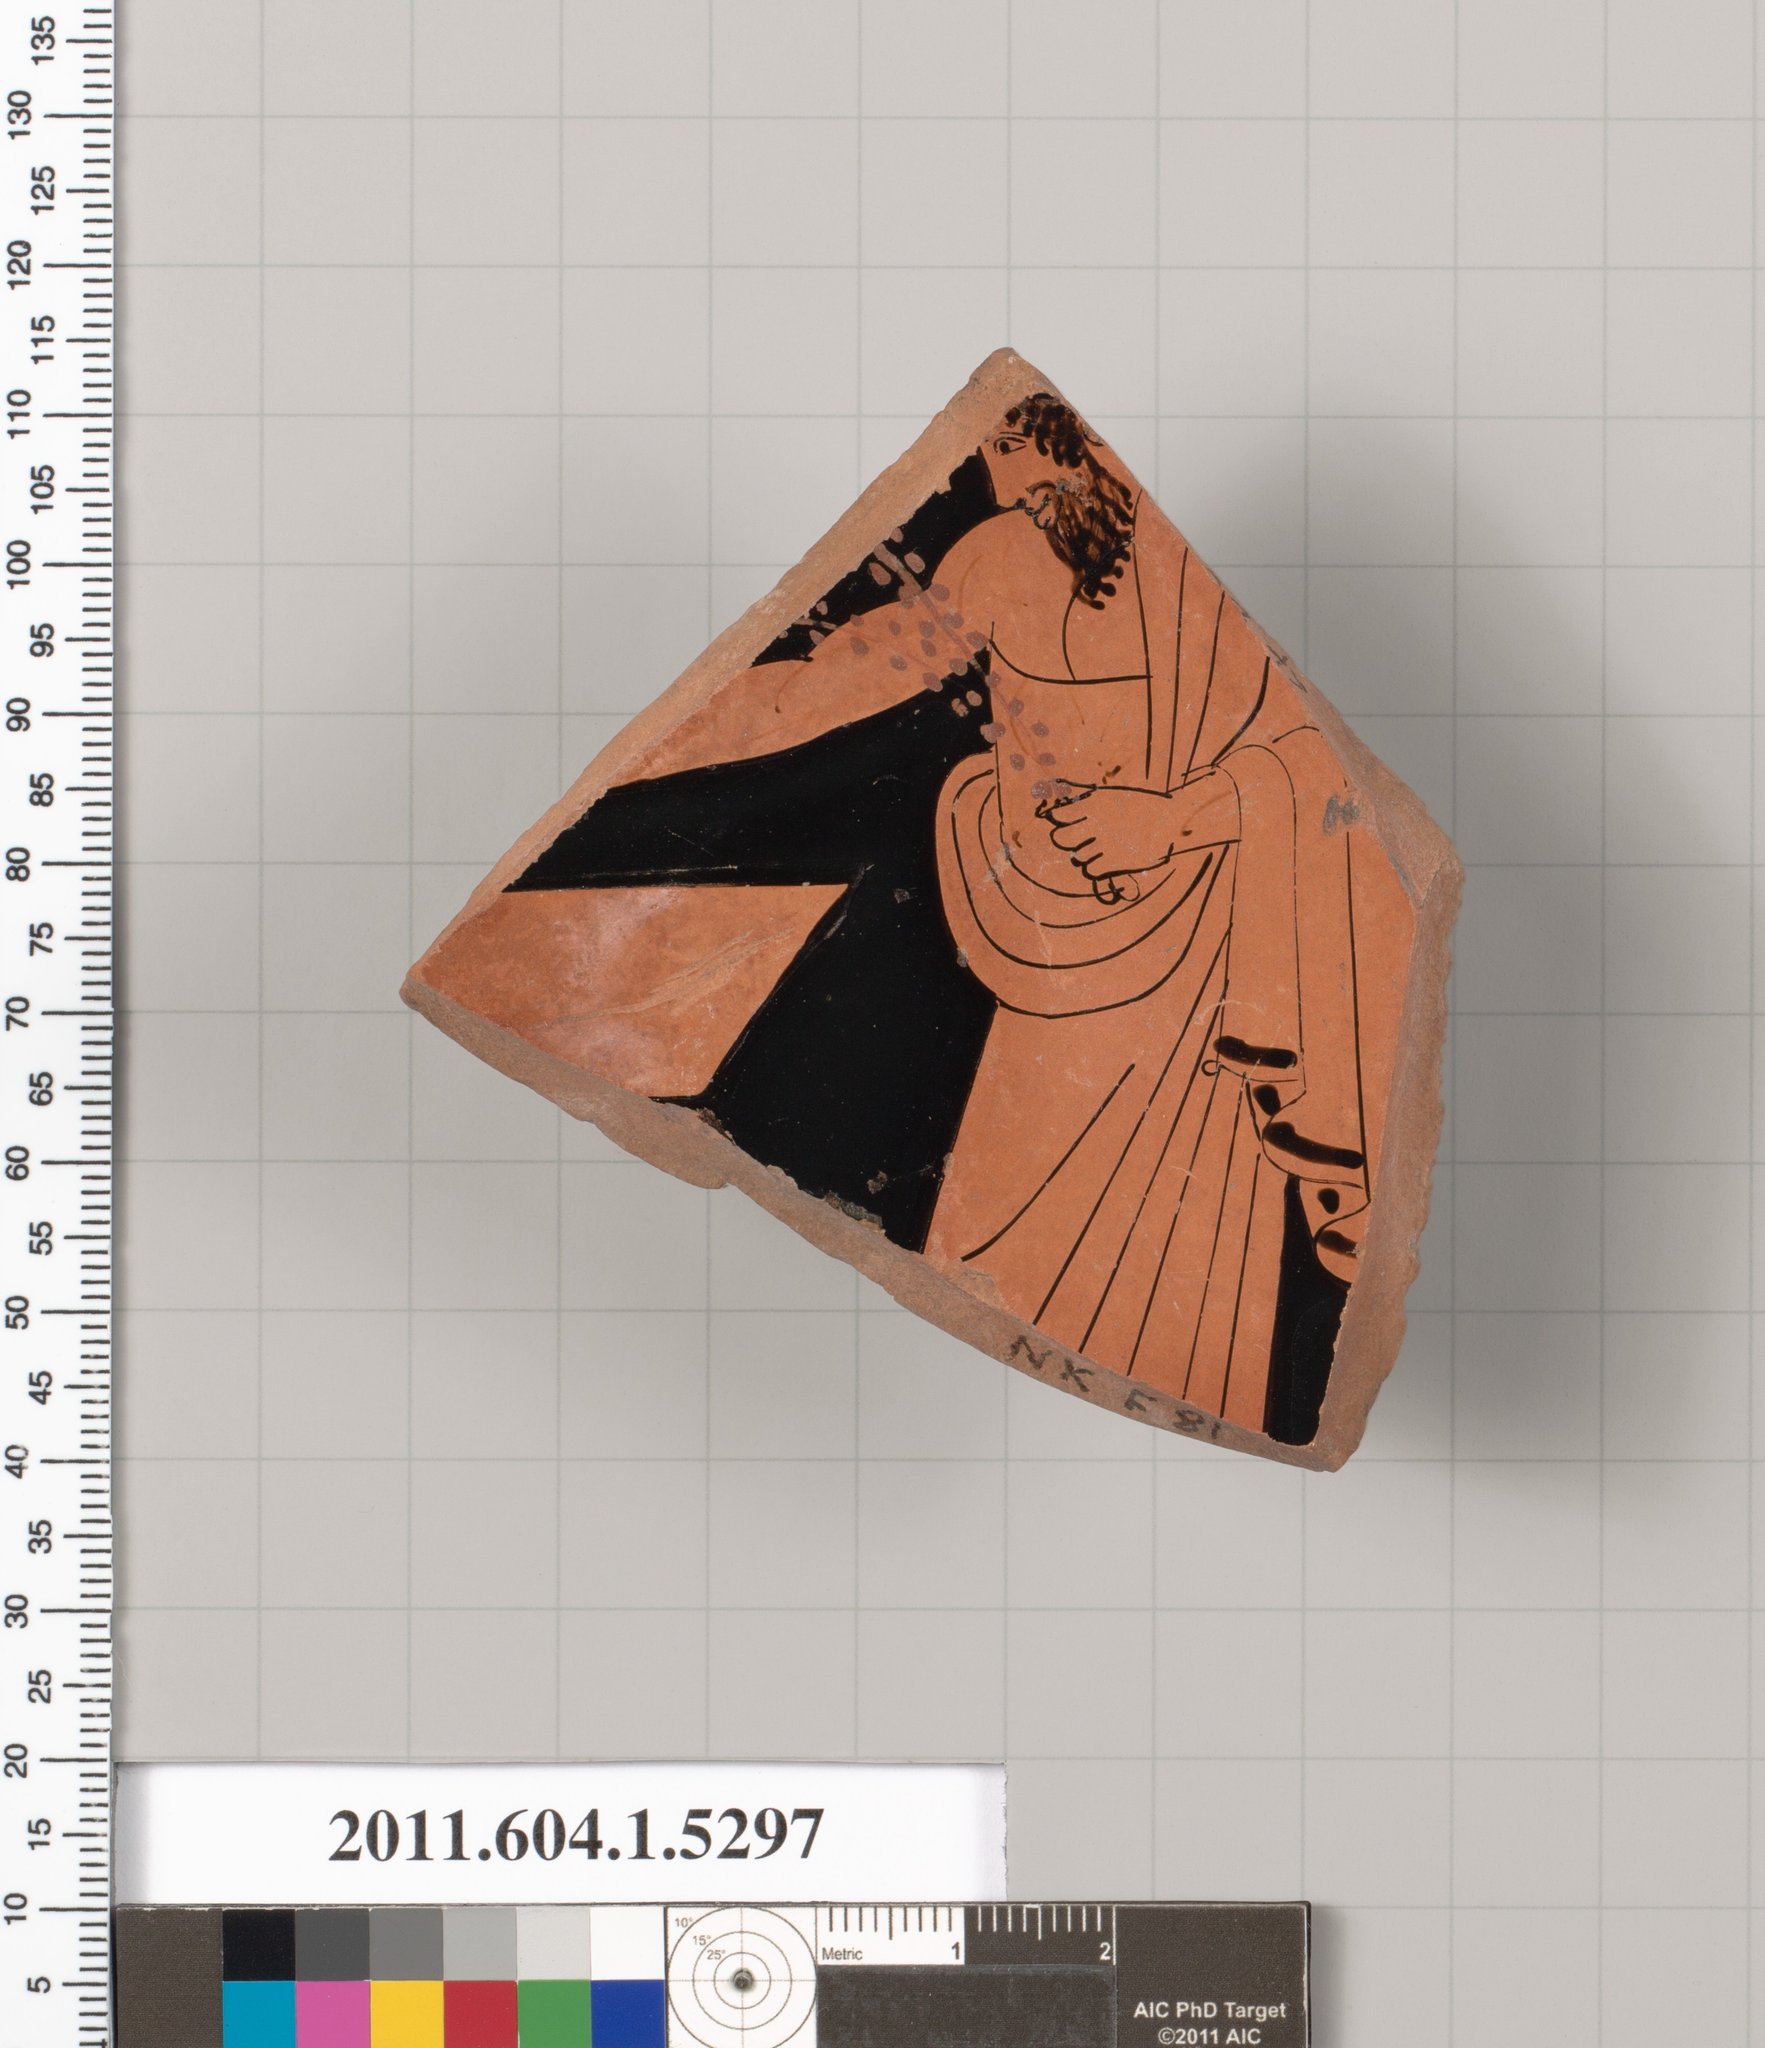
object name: kylix fragment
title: Terracotta fragment of a kylix (drinking cup)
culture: greek, attic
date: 475-451 BCE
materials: terracotta